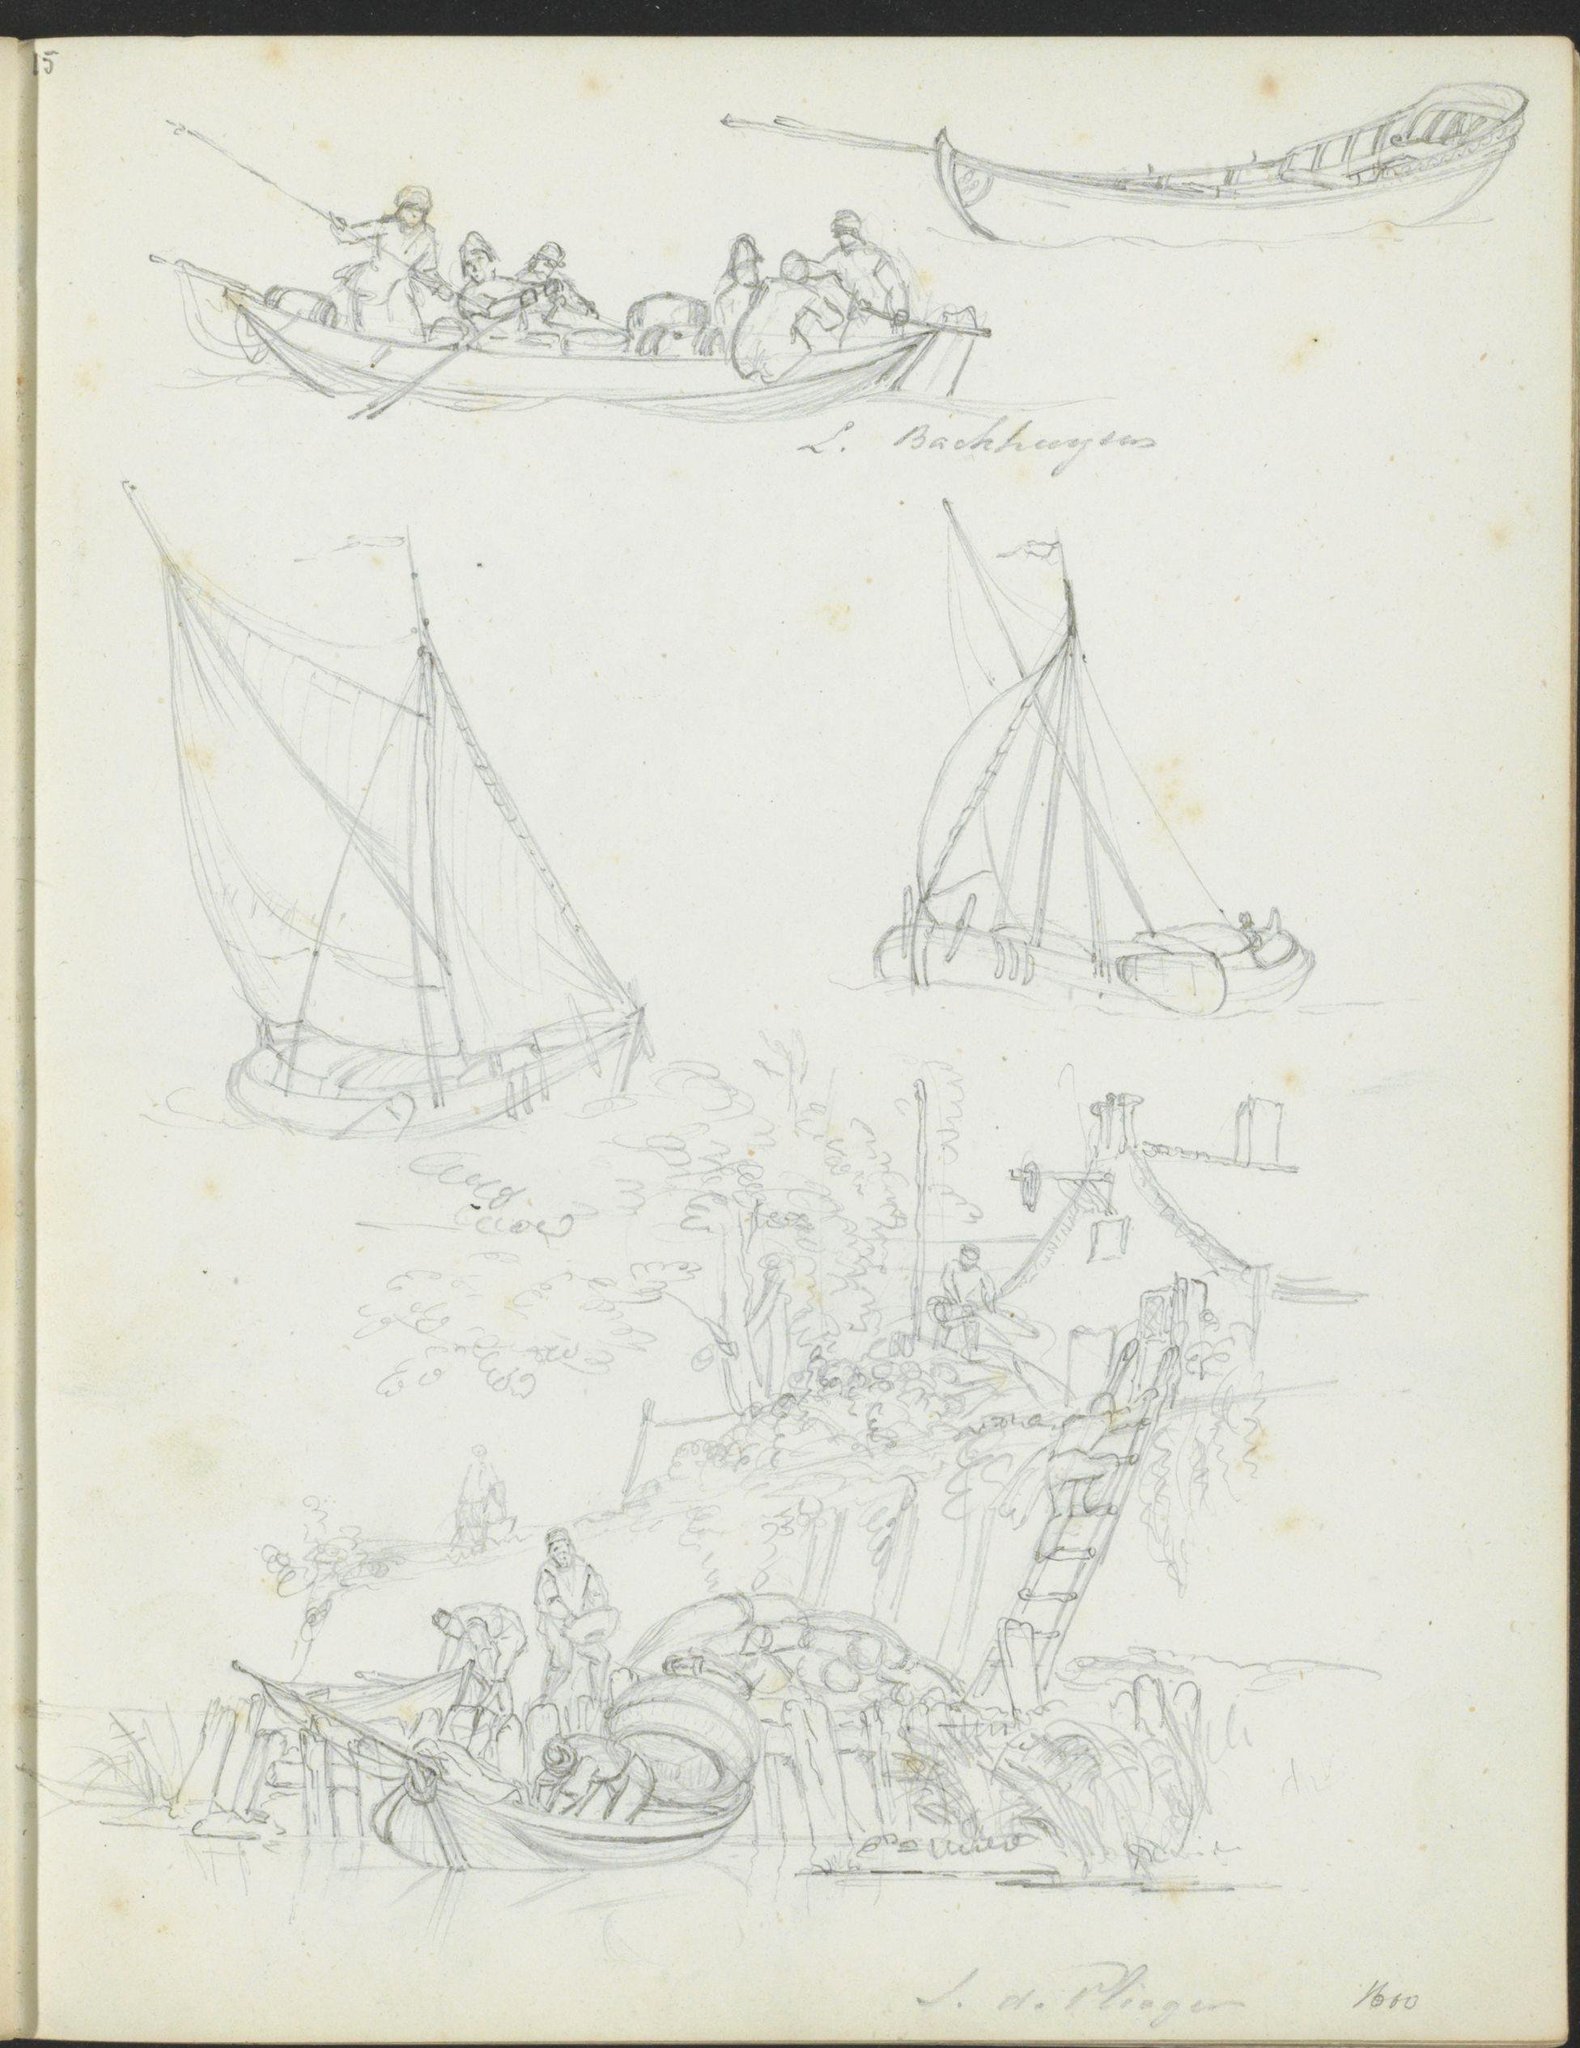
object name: sketchbook leaf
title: Studieblad, onder andere met figuren in een roeiboot en bij een kade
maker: hendrik abraham klinkhamer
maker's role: draughtsman, painter, print maker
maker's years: 1810-1872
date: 1820-1872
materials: paper, pencil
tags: sailing-ship, sailing-boat, rowing-boat, canoe, etc., pier, quay, wharf, traffic on the water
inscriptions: annotation: ‘L. Backhuyzen/ J. de Vlieger 1610’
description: Op de kade worden goederen geladen of gelost. Tevens studies van roei- en zeilboten. Blad 15 recto uit een schetsboek met 21 bladen.